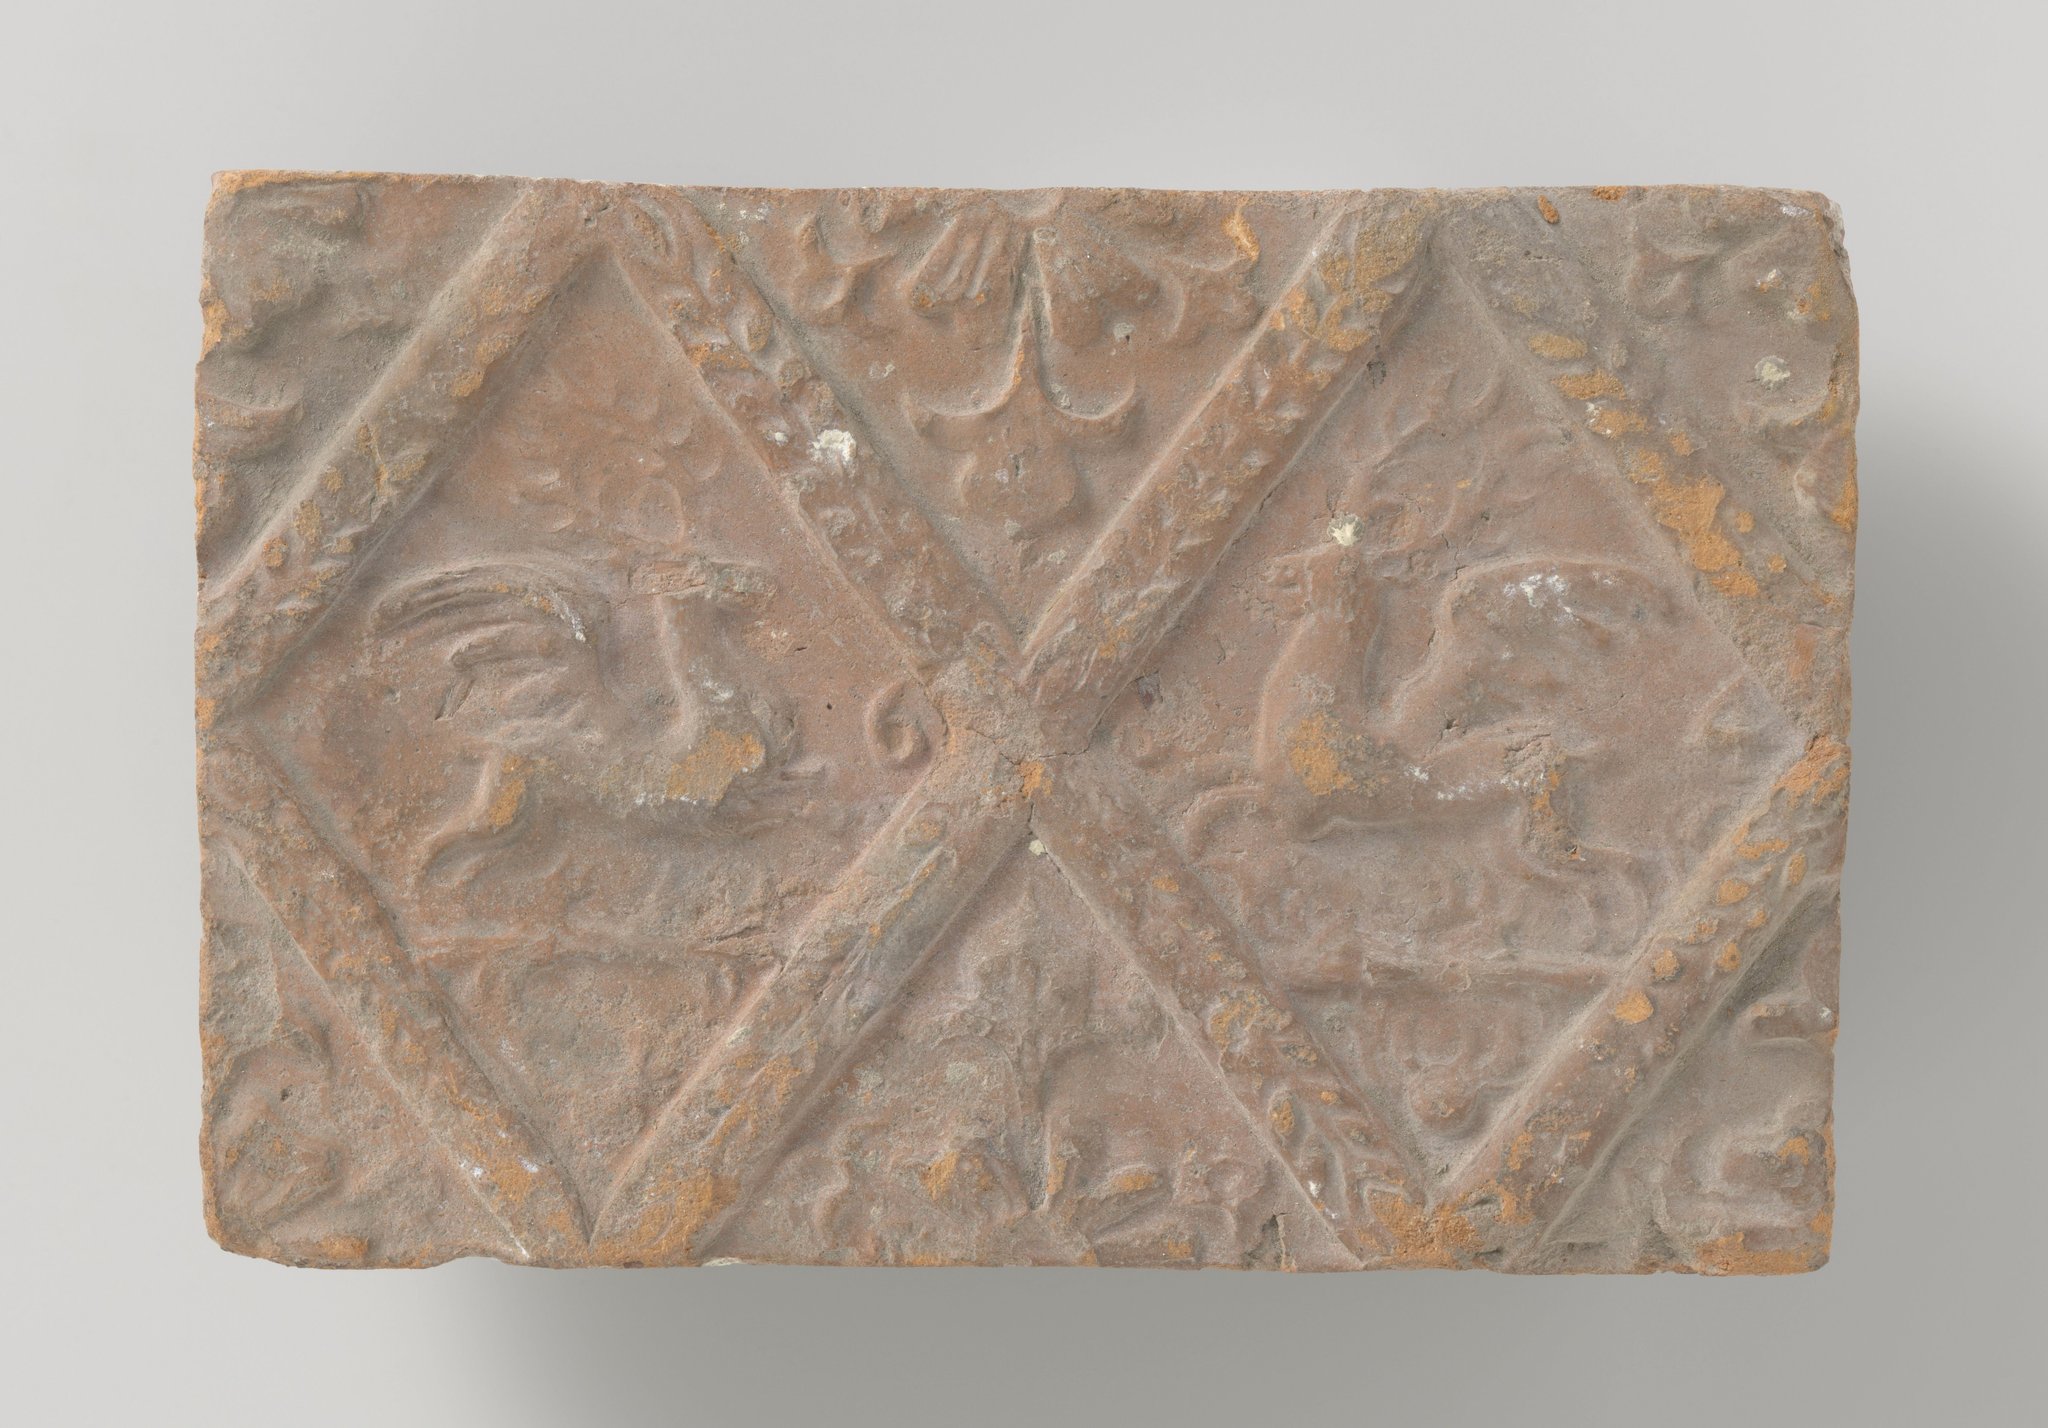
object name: hearthstone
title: Haardsteen met het jaartal 1614 en twee vliegende herten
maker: Anonymous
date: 1614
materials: earthenware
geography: southern netherlands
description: Haardsteen met het jaartal 1614 en twee vliegende herten.